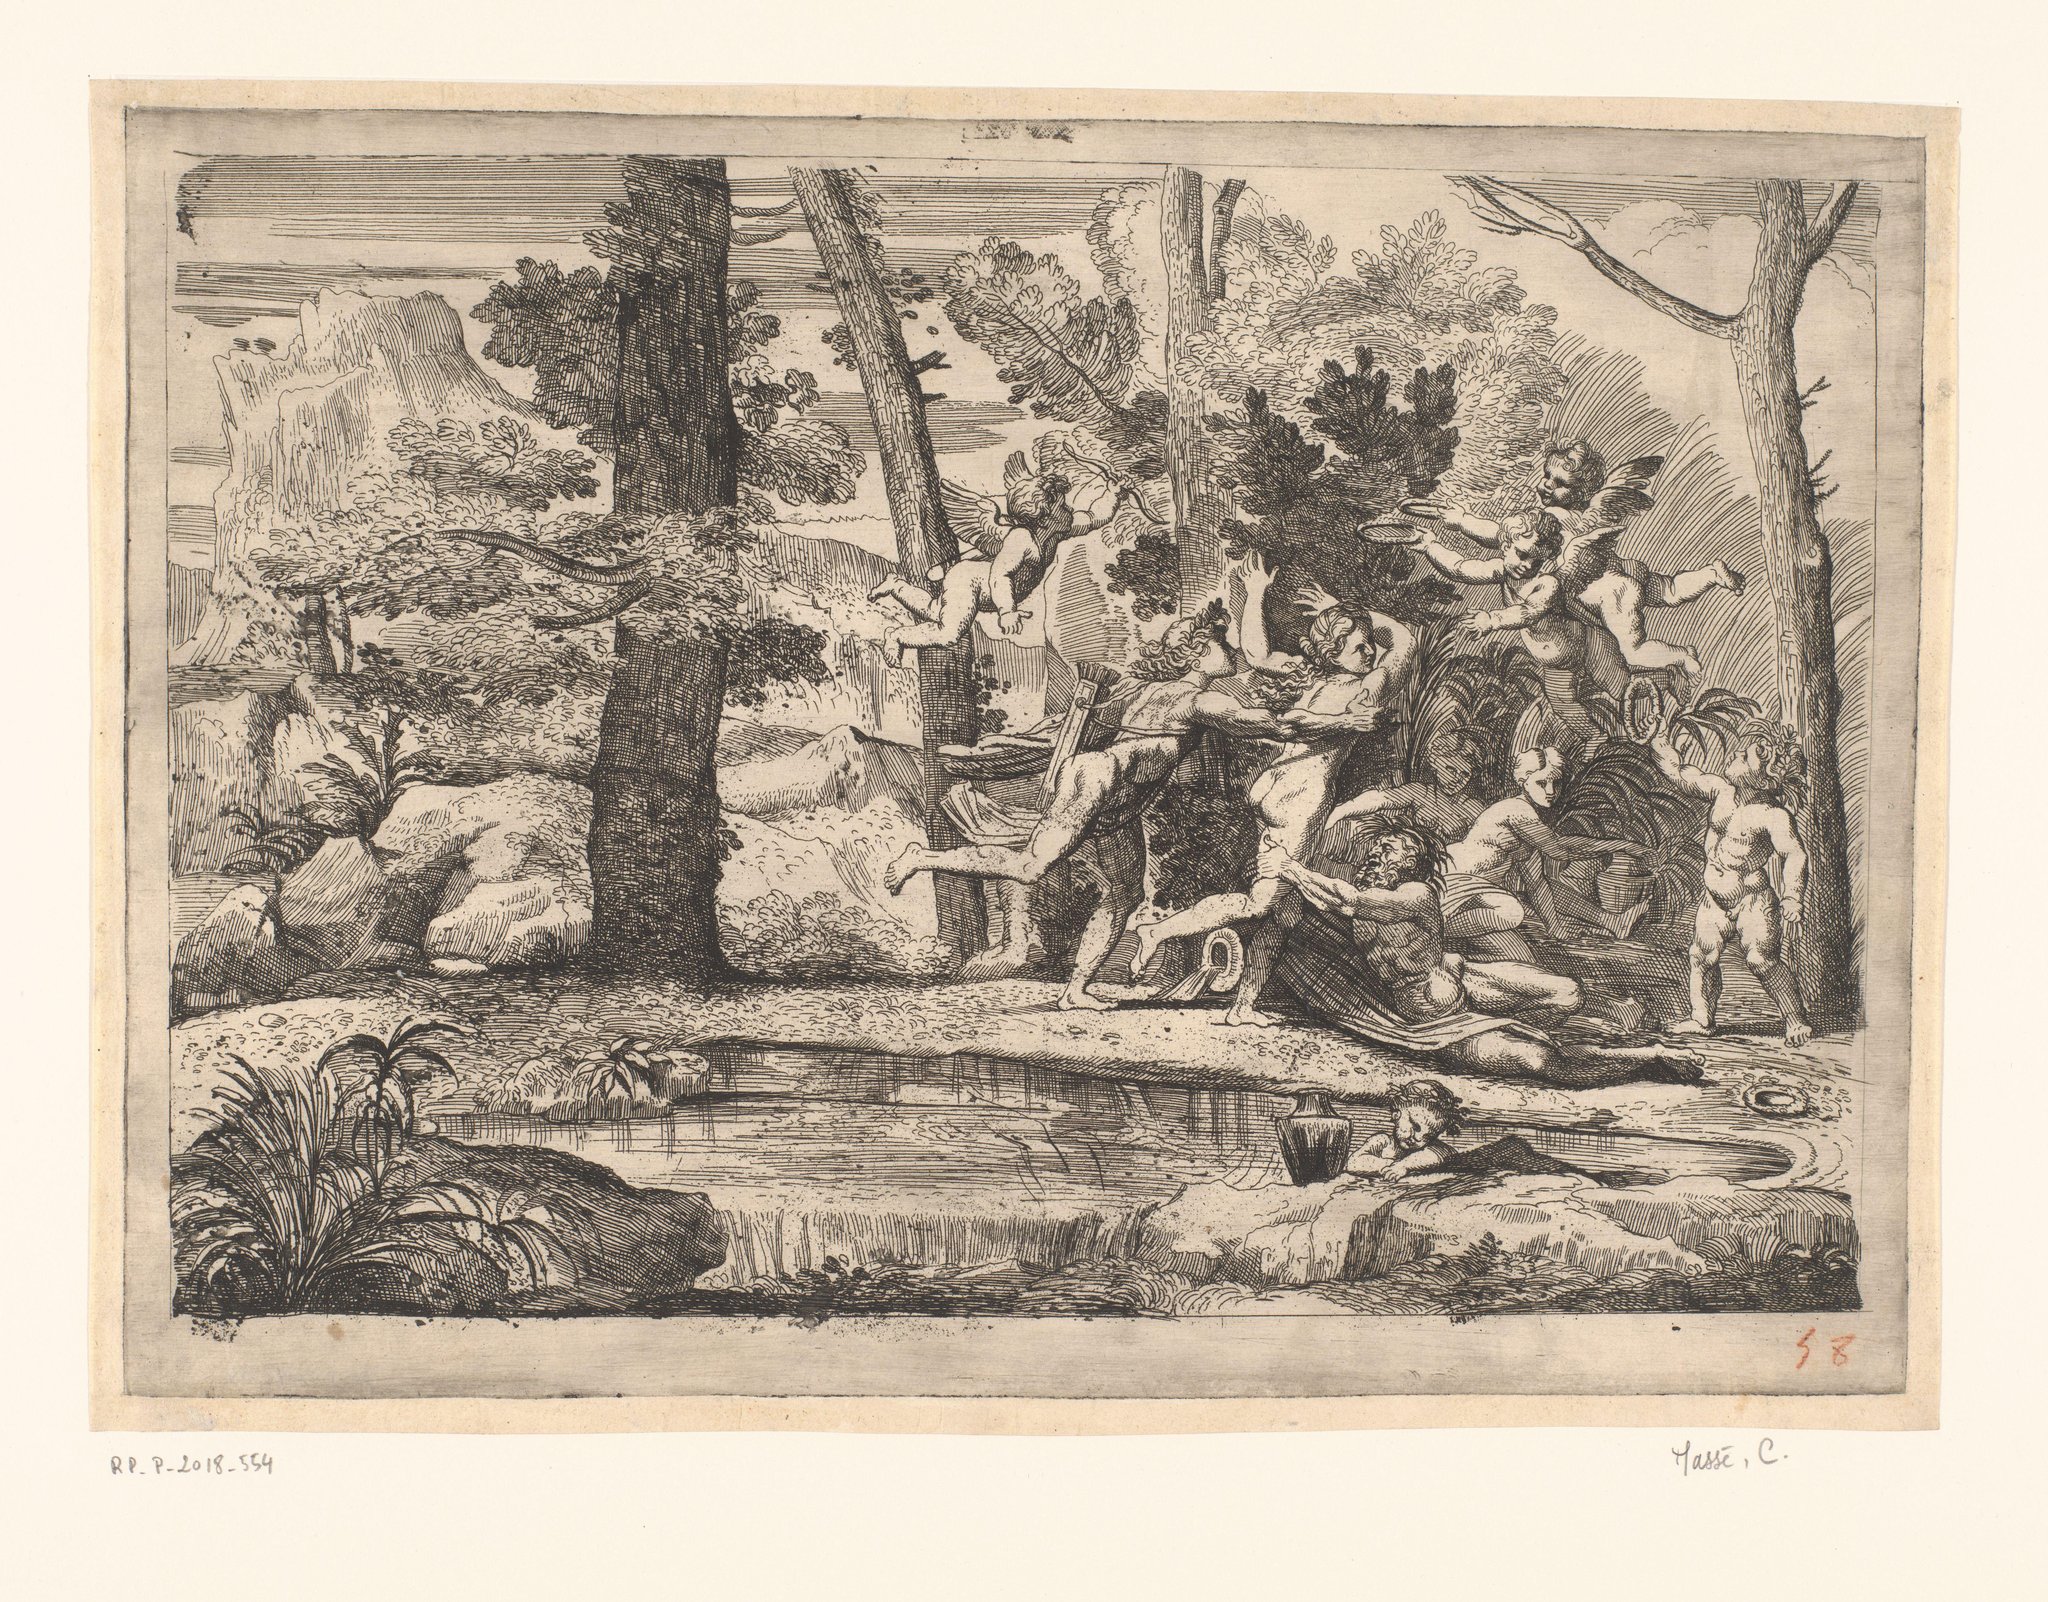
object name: print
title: Apollo en Daphne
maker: claude massé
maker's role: print maker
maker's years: 1631-1670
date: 1666-1670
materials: paper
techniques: etching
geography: france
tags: apollo pursuing the nymph daphne (as yet not metamorphosed)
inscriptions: collector's mark: Lugt 2760, collector's mark: Lugt 2228